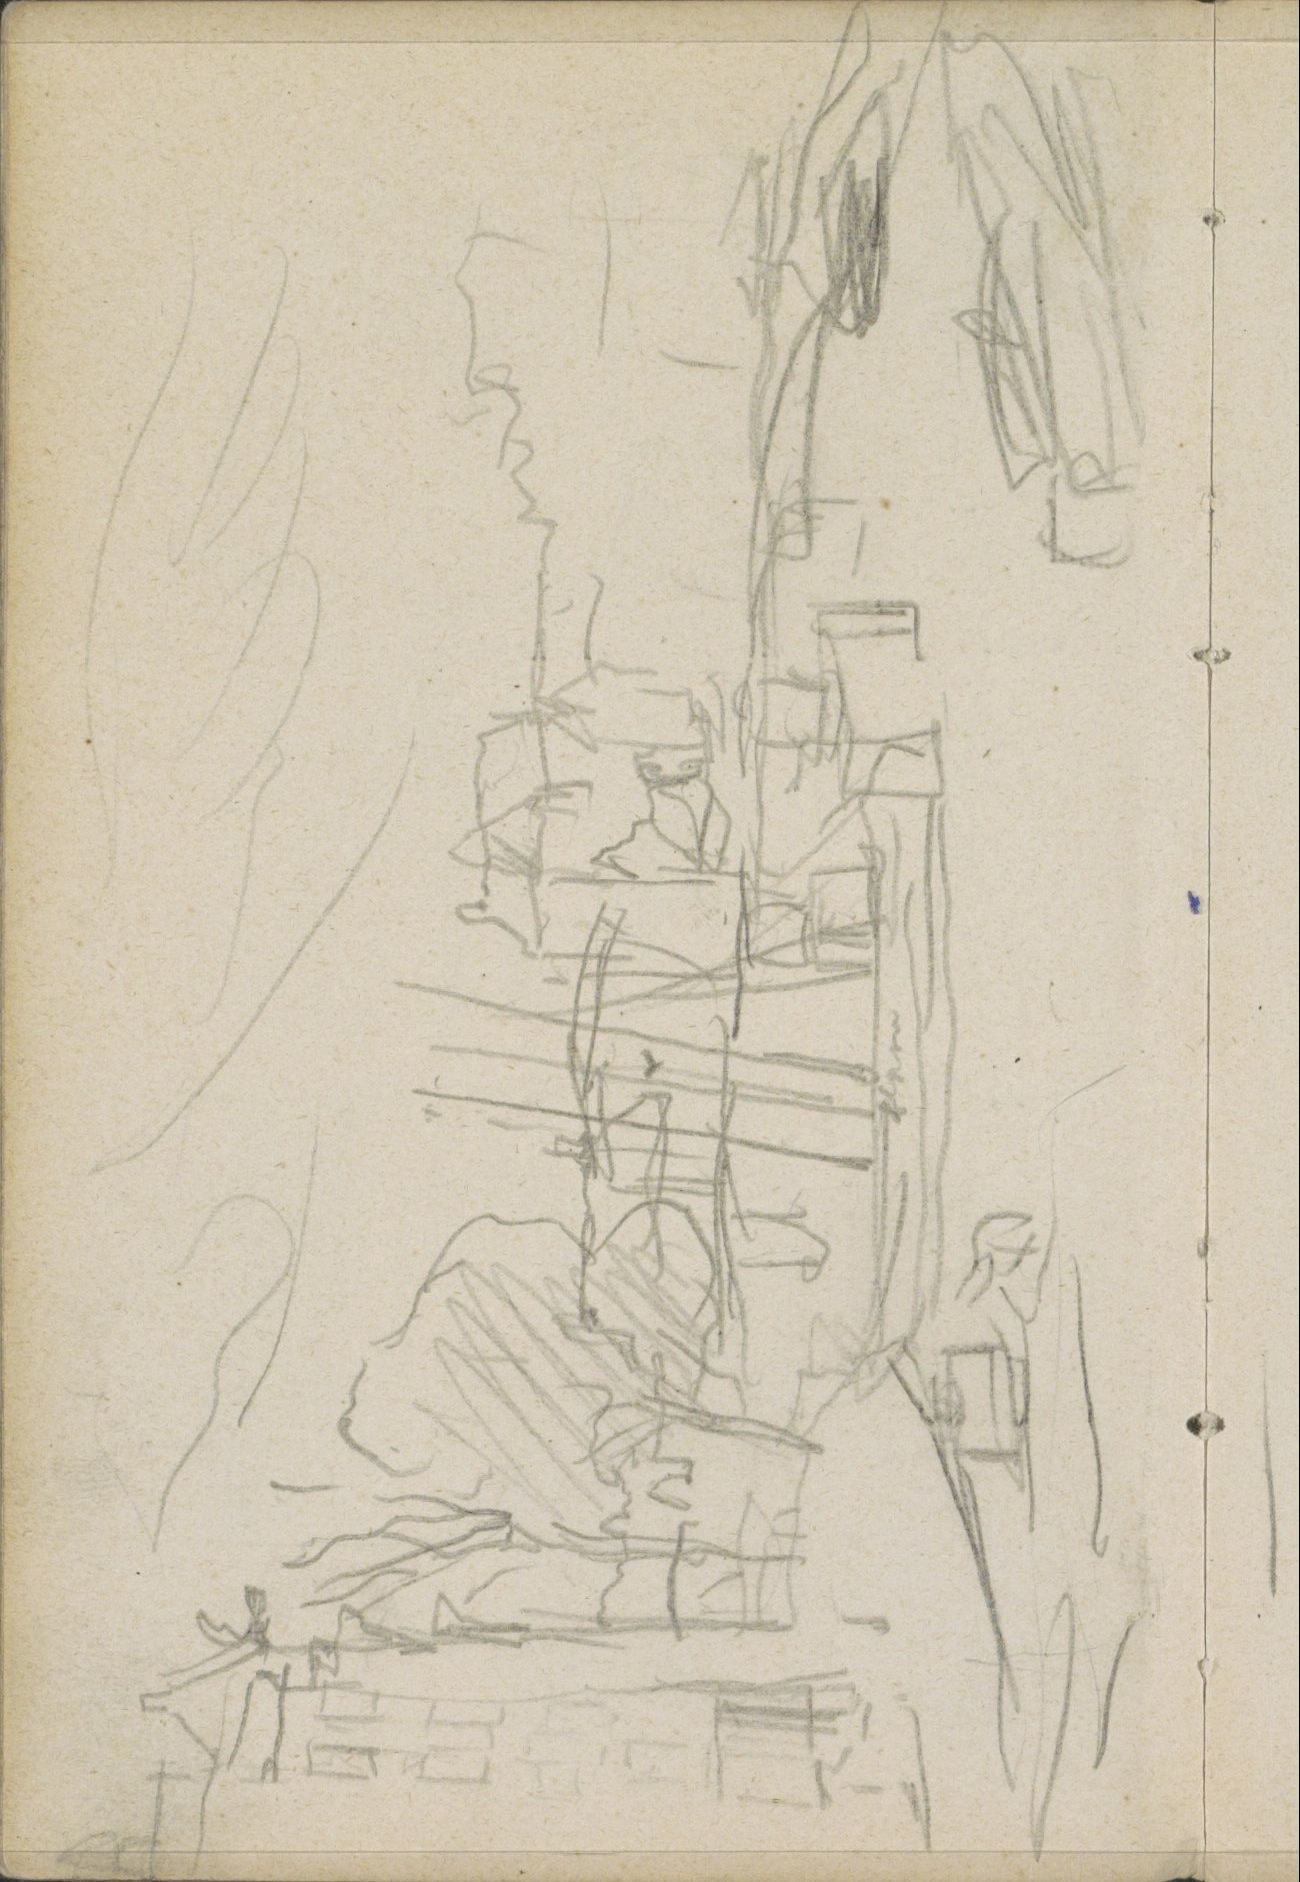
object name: sketchbook leaf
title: Gezicht op het Damrak te Amsterdam met boten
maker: george hendrik breitner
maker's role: draughtsman, painter, print maker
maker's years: 1857-1923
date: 1902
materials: paper, pencil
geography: amsterdam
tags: urban housing, ships (in general), canals, waters (in city)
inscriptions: kleurnotitie, handgeschreven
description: Pagina 5 uit een schetsboek met 46 bladen vervaardigd in de omgeving van Amsterdam, Rotterdam en Haarlem.